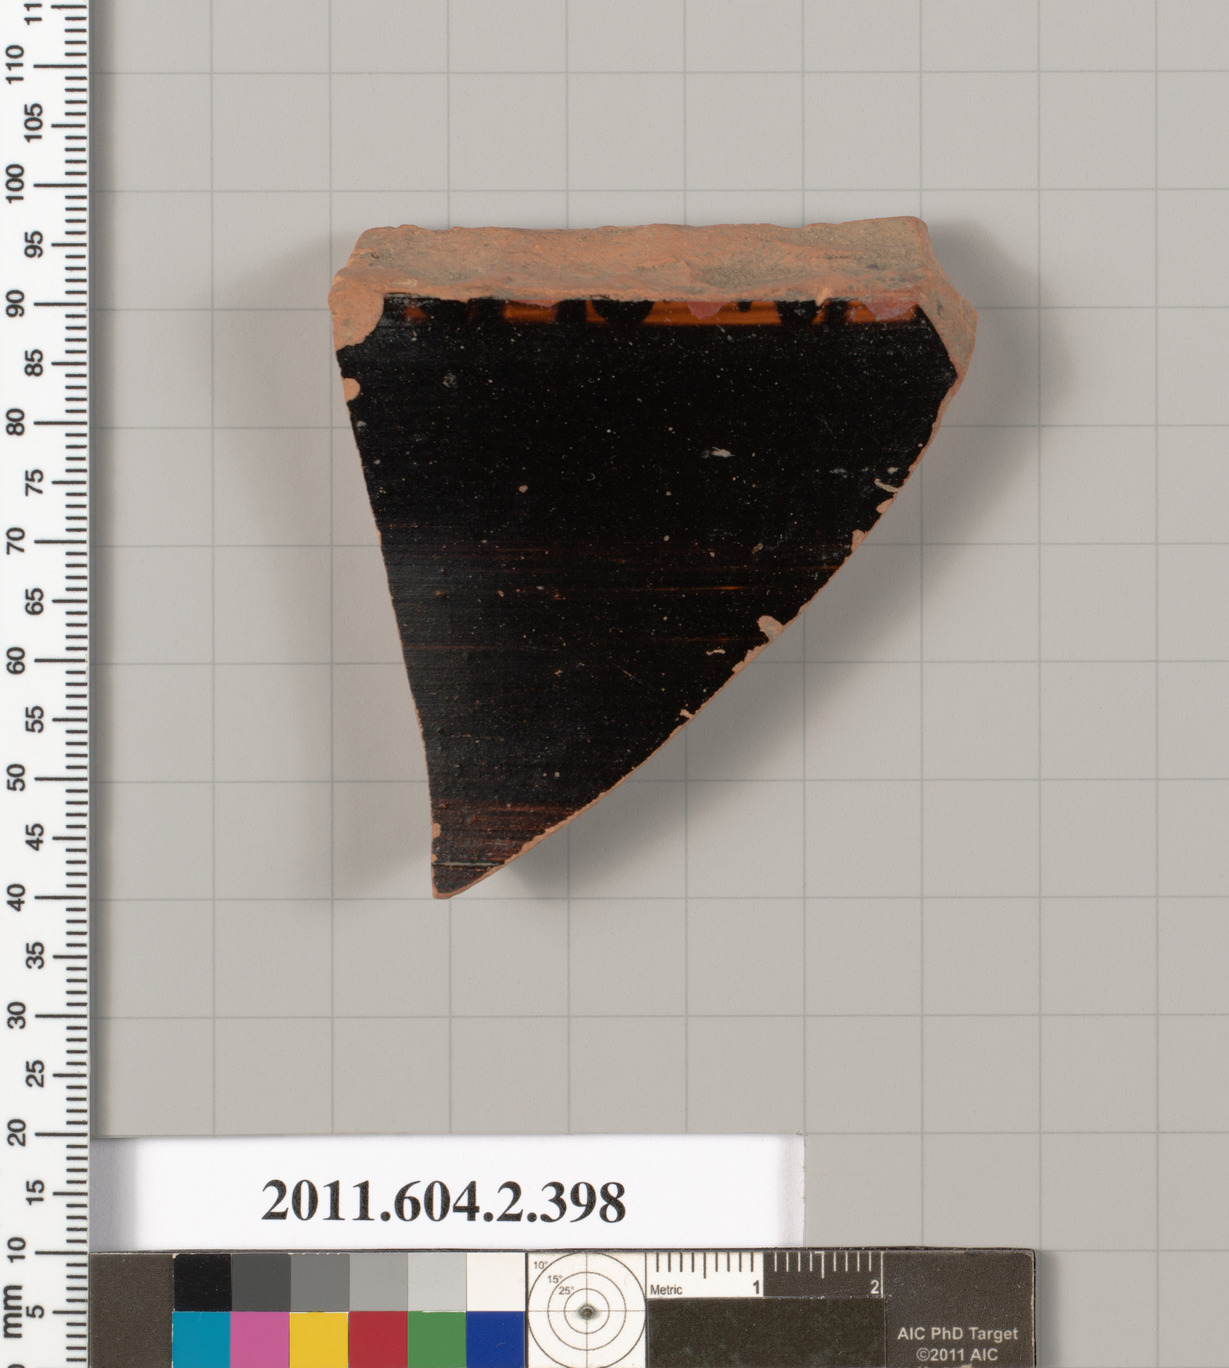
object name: column krater fragment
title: Terracotta fragment of a column-krater (bowl for mixing wine and water)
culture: greek, attic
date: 475-451 BCE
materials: terracotta